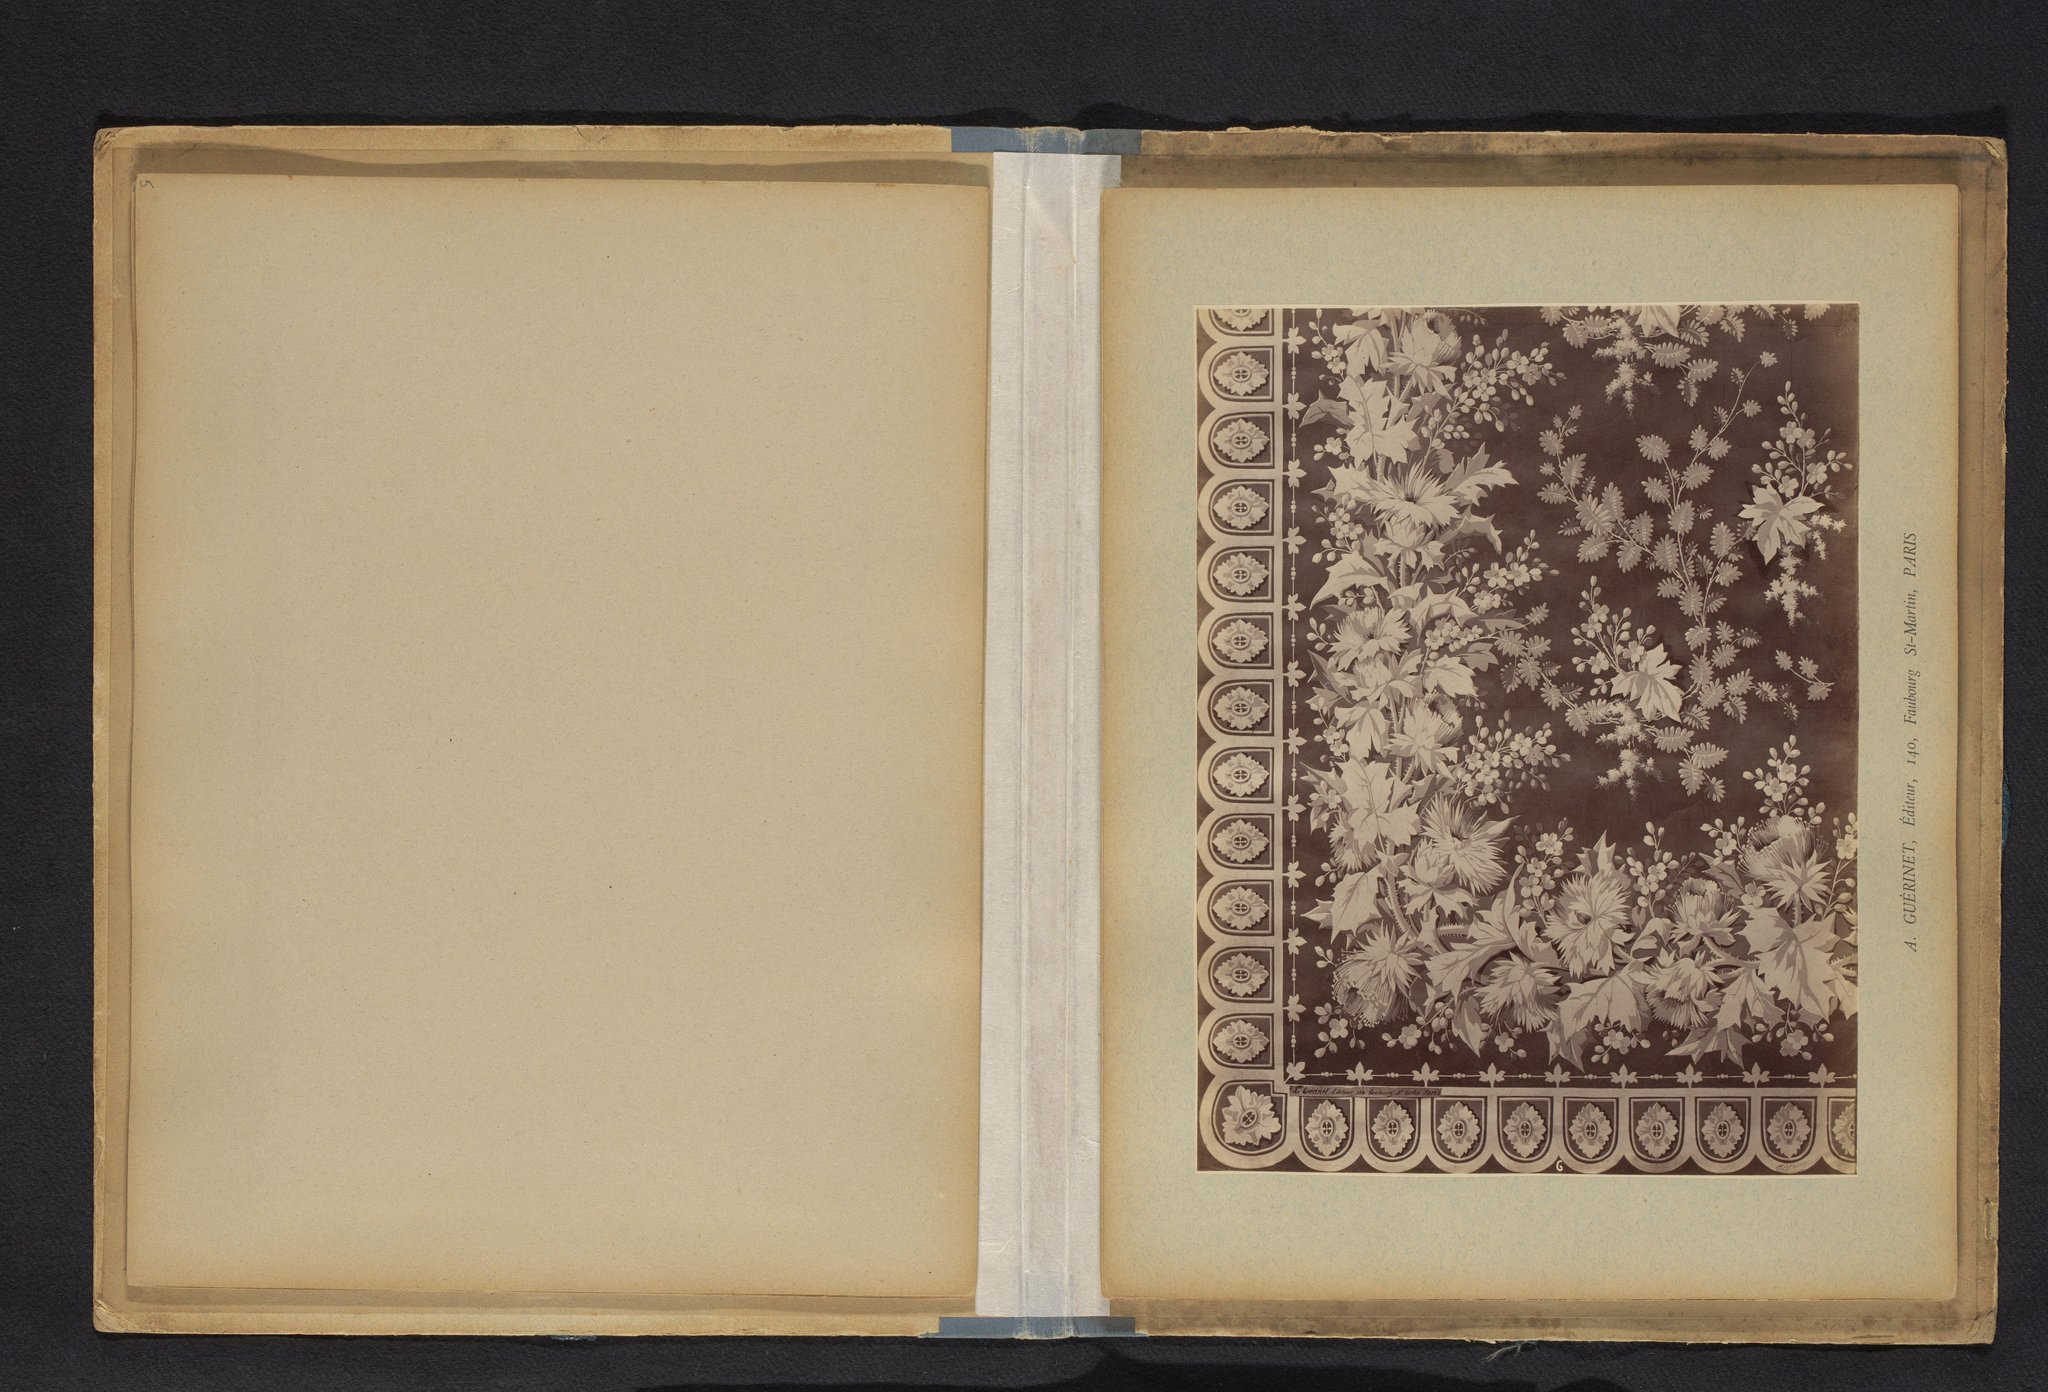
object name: photograph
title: Fotoreproductie van een decoratief patroon met bloemen en planten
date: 1890-1900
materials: photographic support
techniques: albumen print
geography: paris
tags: ornament derived from plant forms, flowers ~ ornament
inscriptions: number: ‘6’